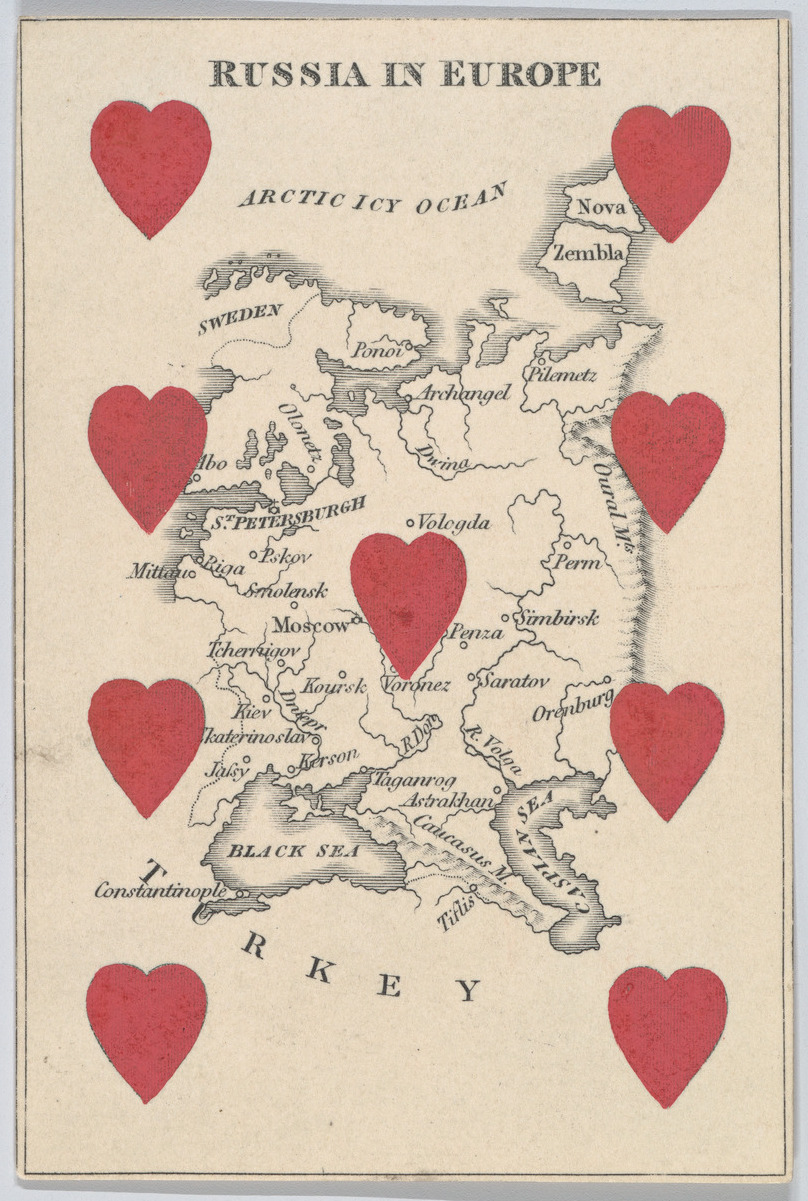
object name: print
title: Russia in Europe, from "Court Game of Geography"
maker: william and henry rock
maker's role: publisher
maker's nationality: british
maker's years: 1821-1884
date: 1838-1855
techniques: engraving, hand coloring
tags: playing cards,maps